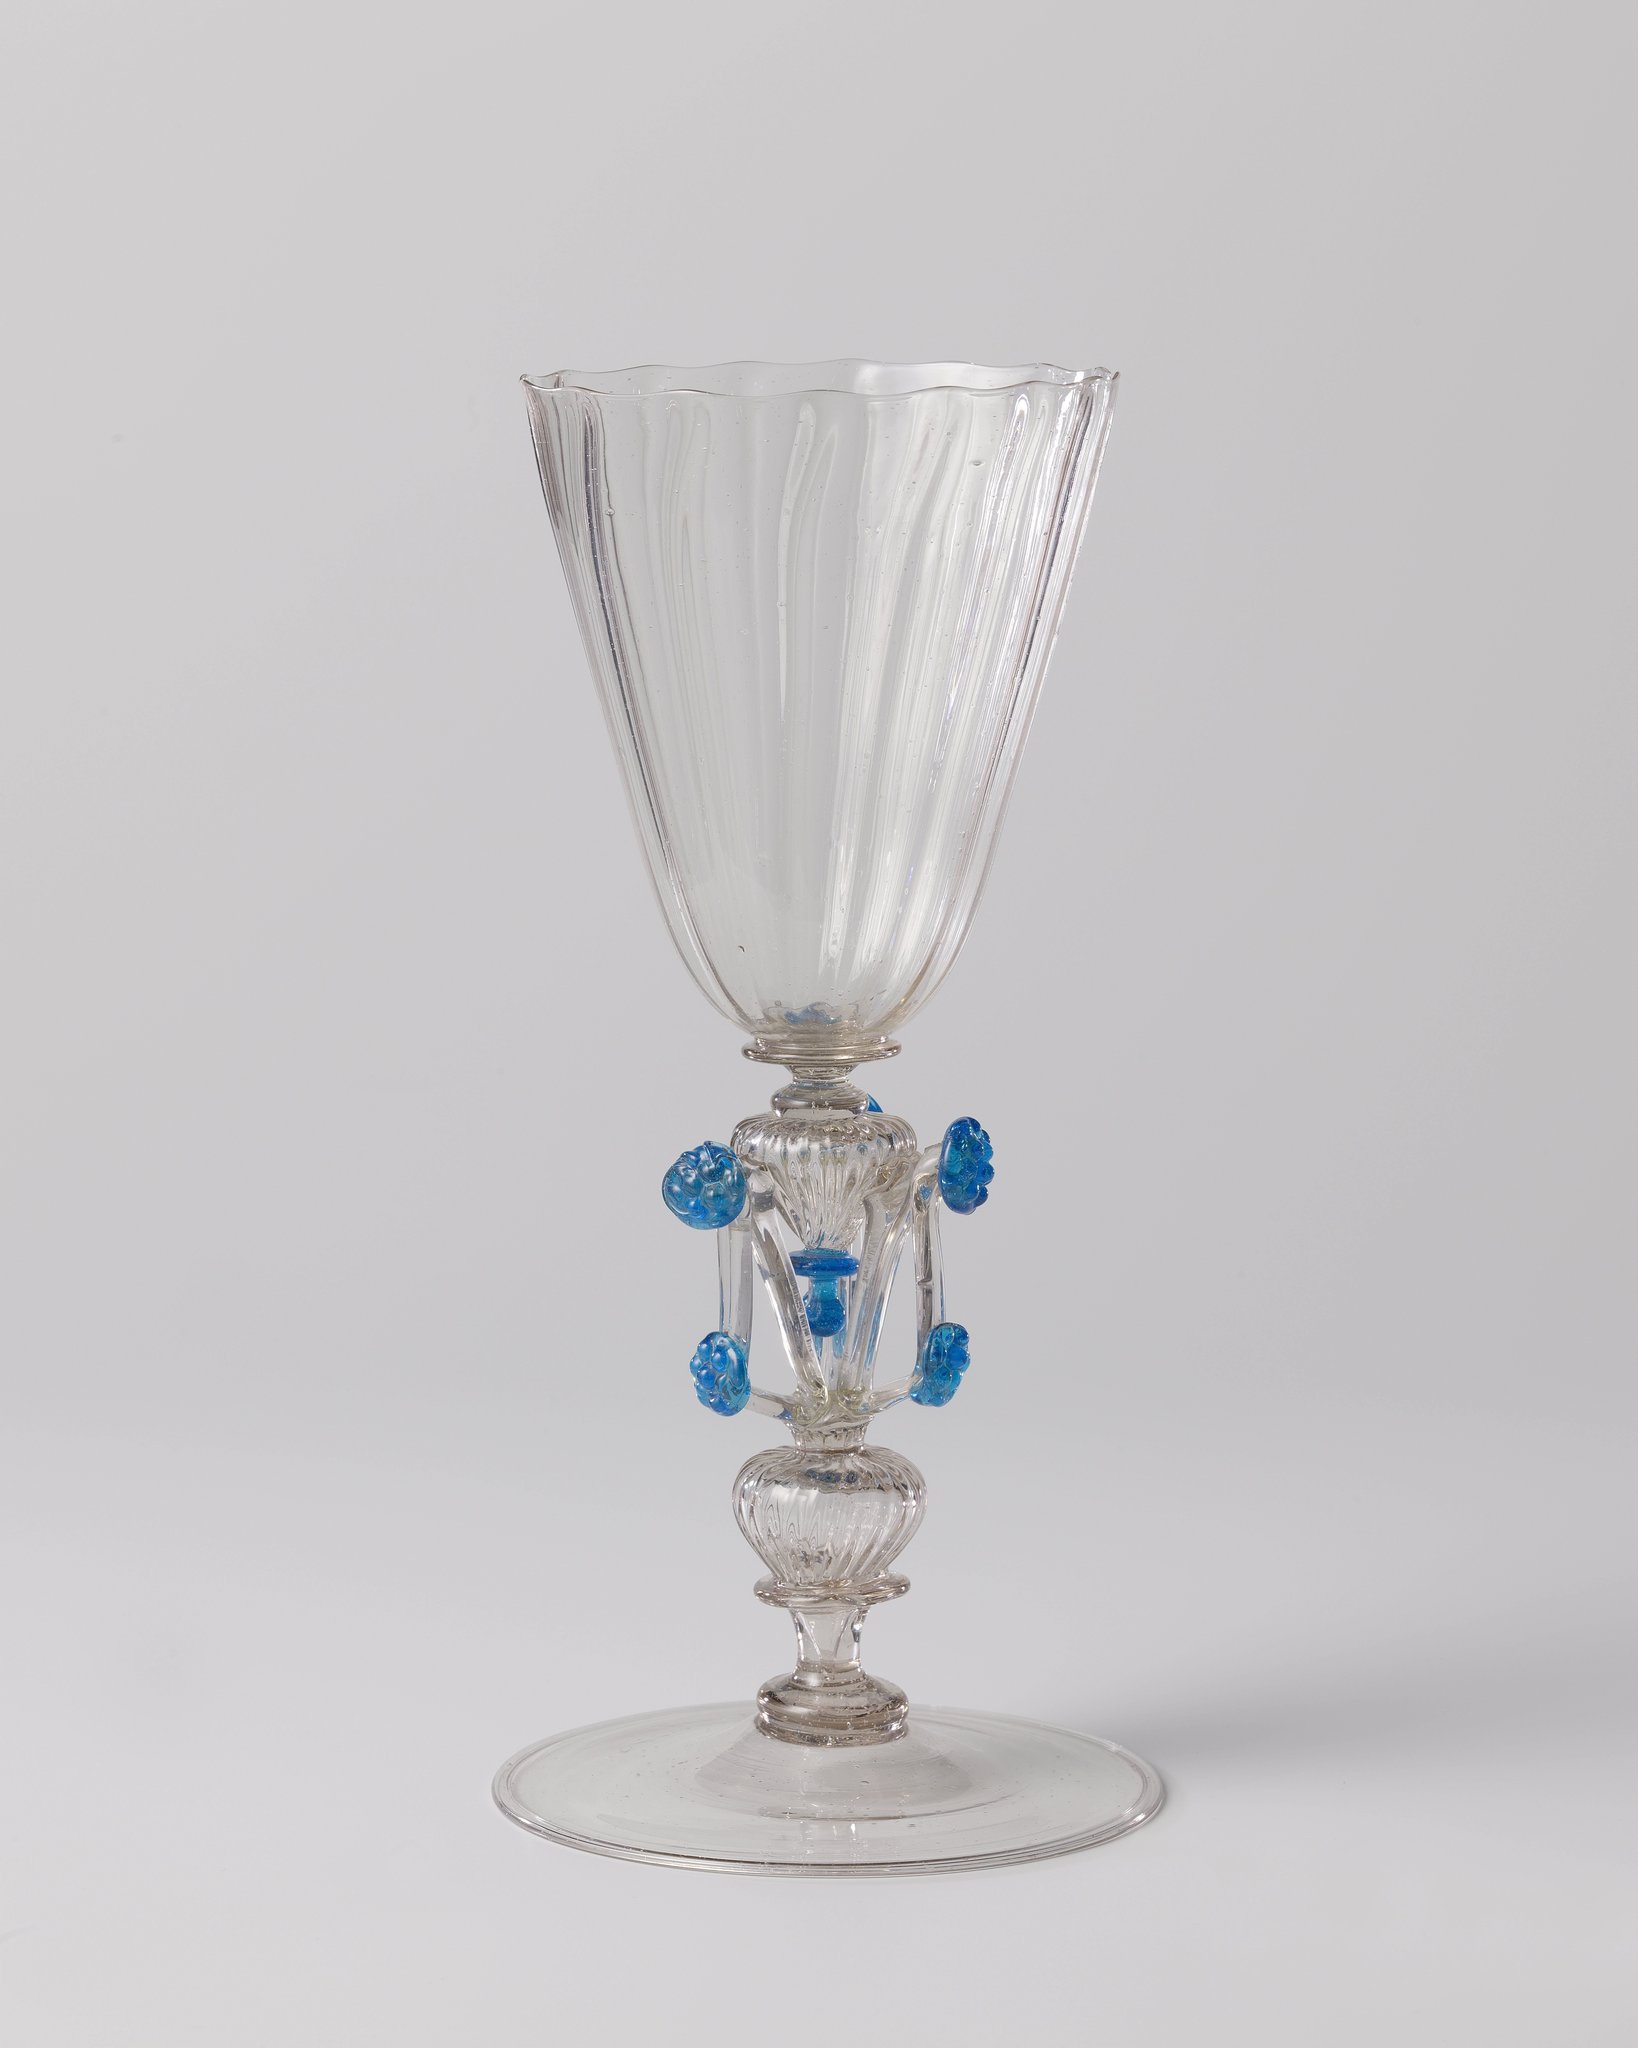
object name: goblet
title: Bokaal met trechtervormige kelk met verticale, licht getordeerde optisch geblazen ribben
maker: Anonymous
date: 1600-1650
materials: glass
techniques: façon de venise, glassblowing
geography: low countries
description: Goblet. Netherlands, façon de Venise, c. 1600-1650. A.J. Enschedé bequest, 1896.